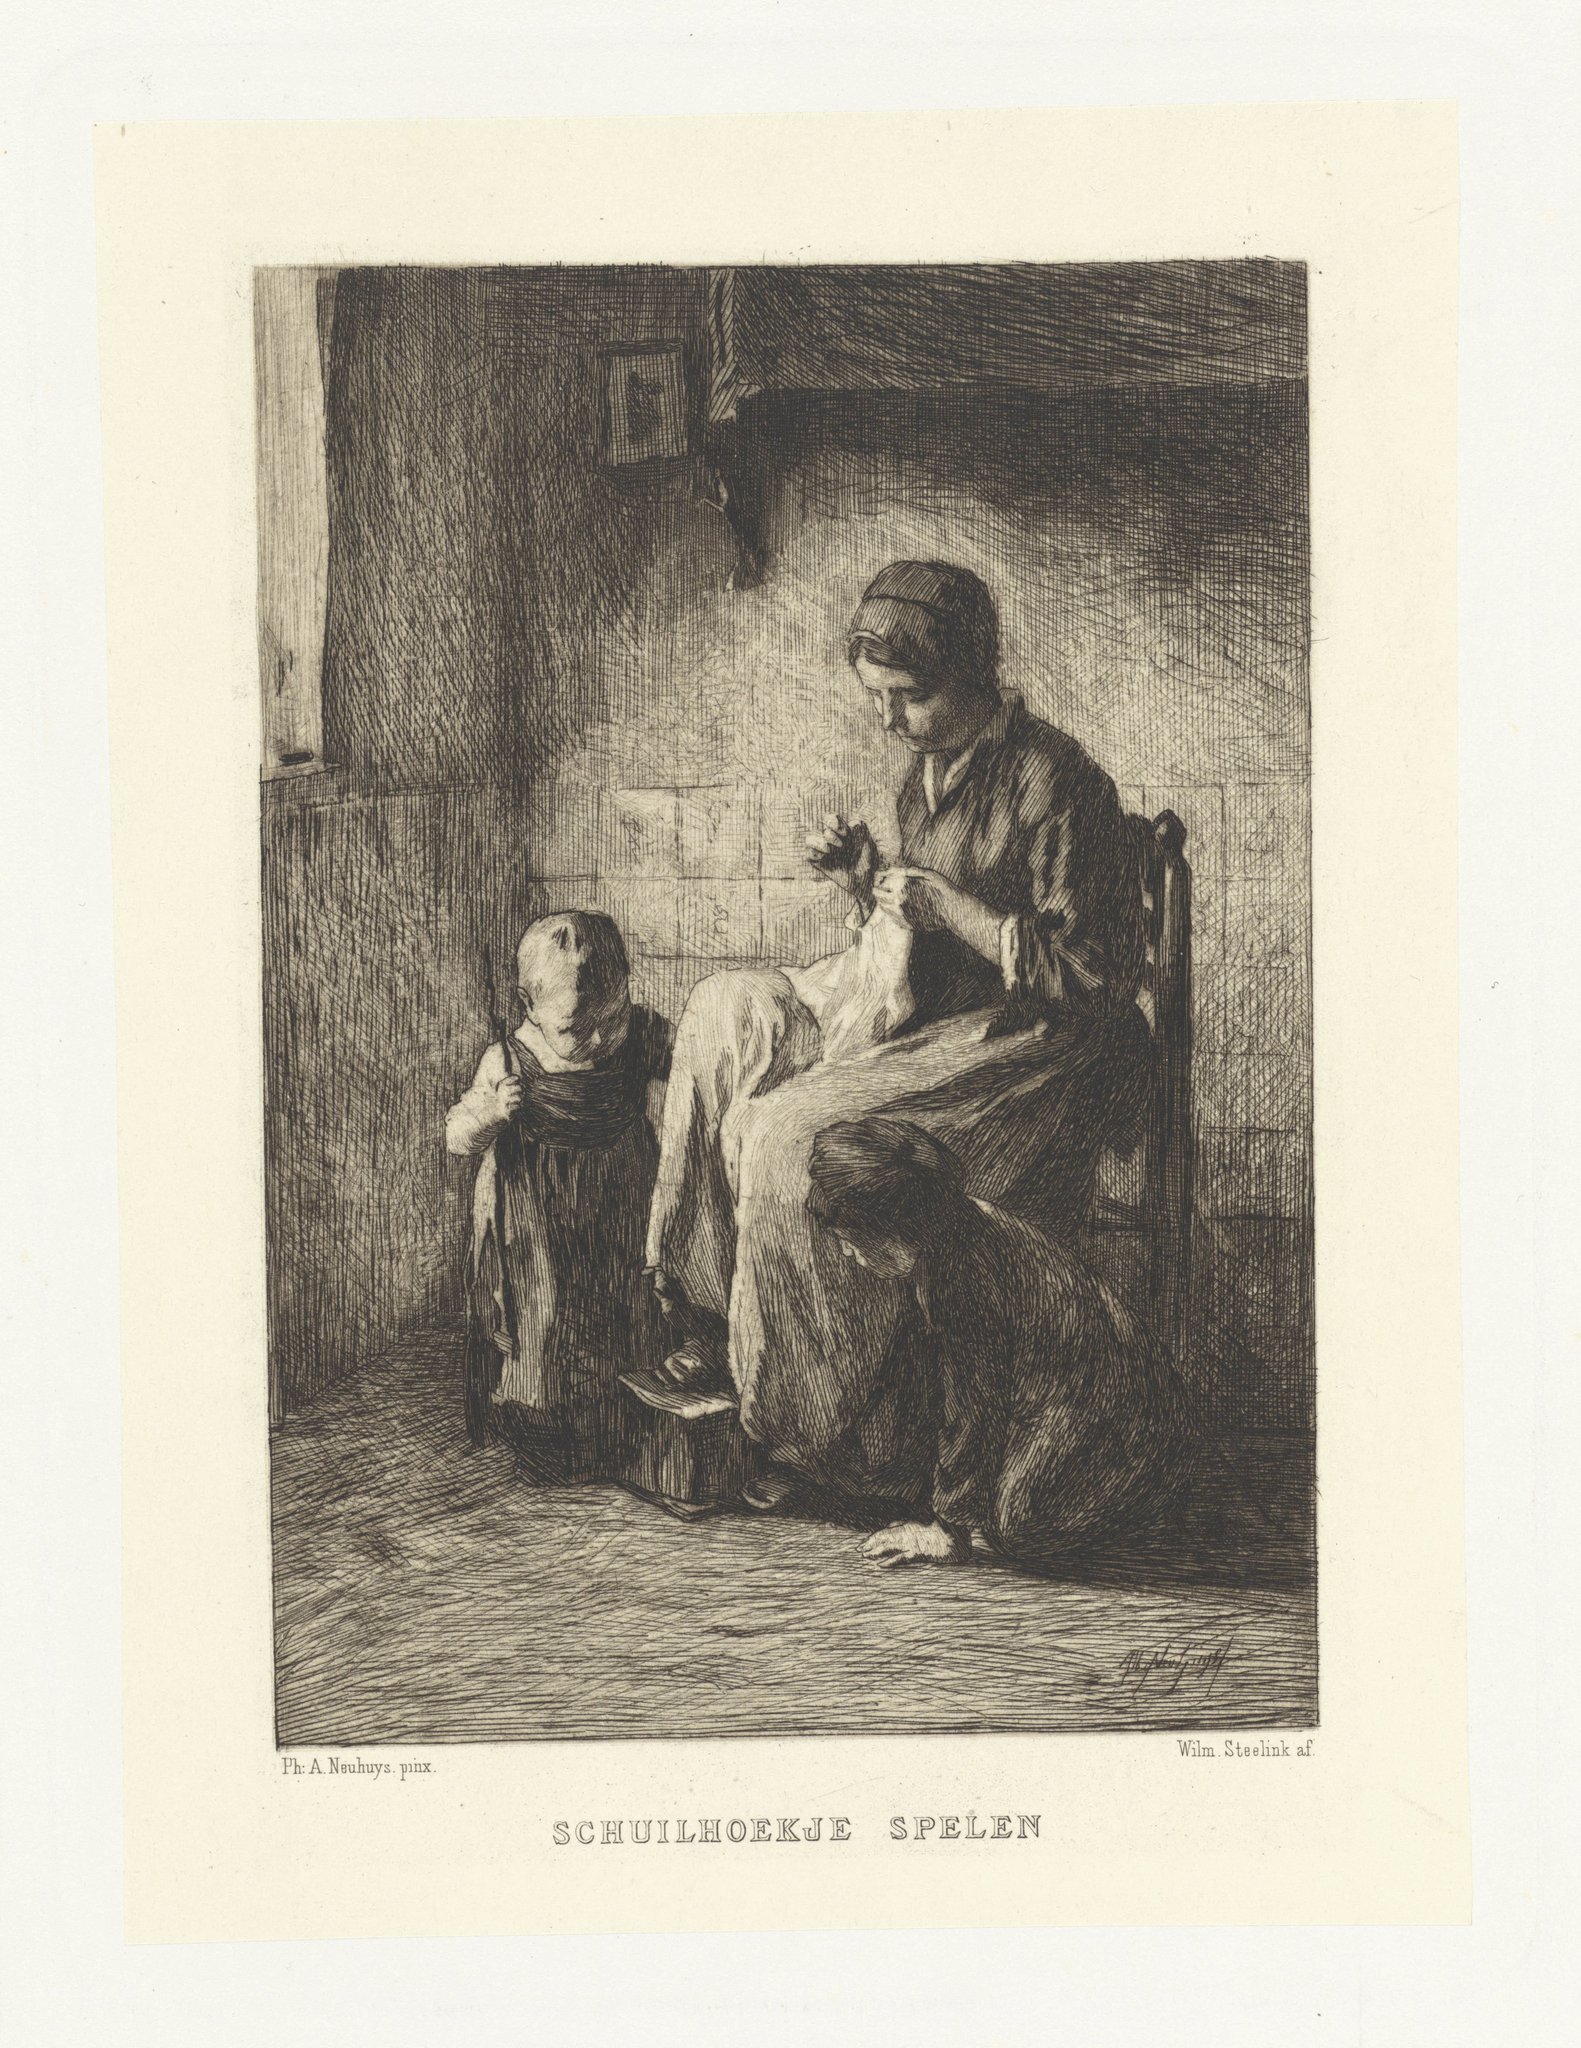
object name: print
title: Verstoppertje spelen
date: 1866-1913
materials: paper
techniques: etching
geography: netherlands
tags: hide-and-seek, sewing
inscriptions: collector's mark: Lugt 2228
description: Twee kinderen spelen verstoppertje. Hun moeder zit op een stoel tussen hen en is bezig met handwerken.